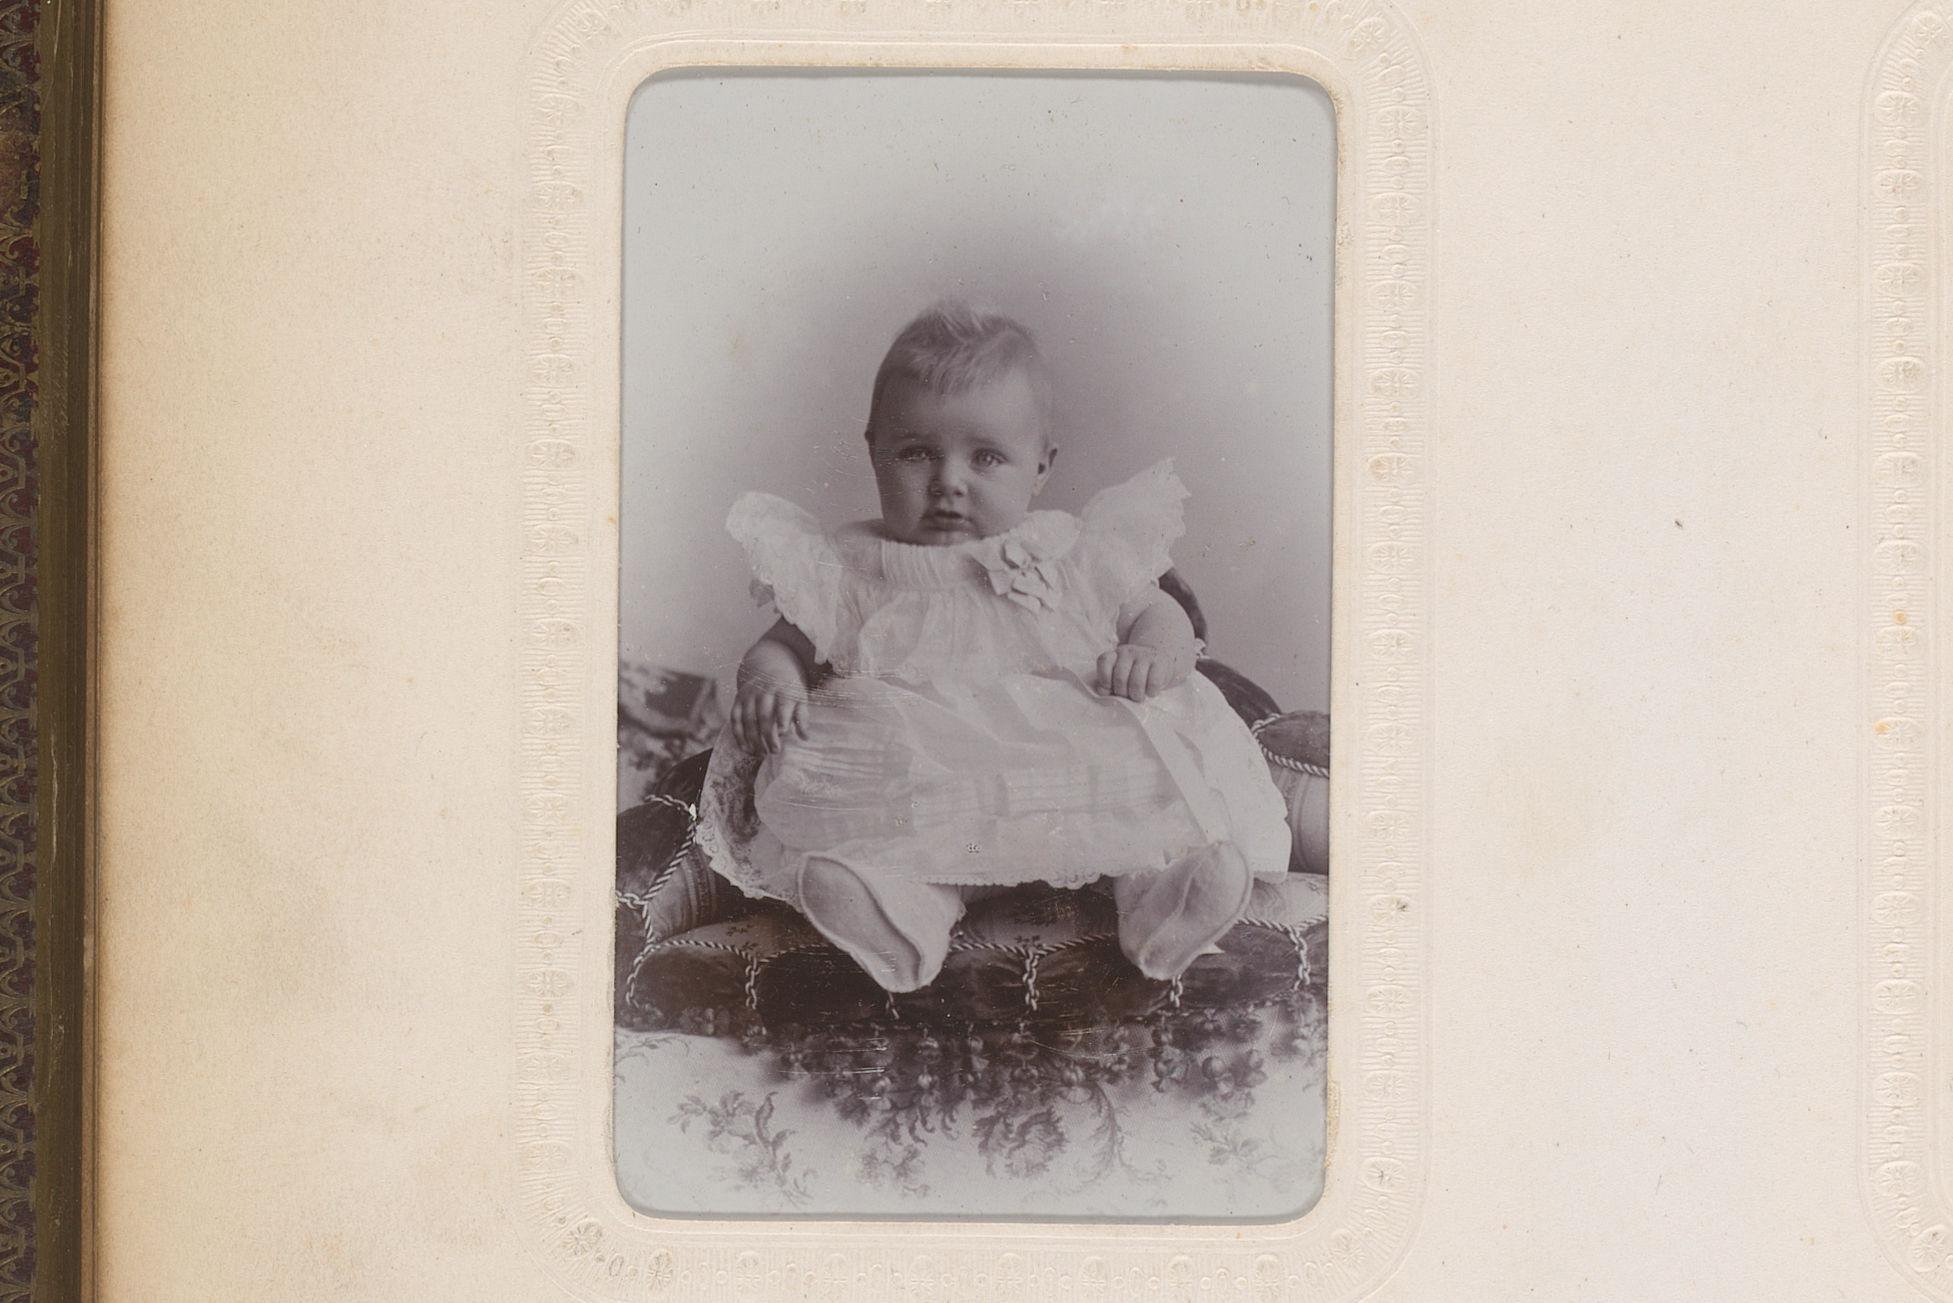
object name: album leaf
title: Portret van een jongen in matrozenpak, staand bij een tafel met open boek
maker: h.c. de graaff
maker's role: fotograaf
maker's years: 1853-1932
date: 1898-1919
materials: cardboard, photographic support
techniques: collodion silver print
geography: amsterdam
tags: ensemble of pieces of clothing: sailor suit, boy (child between toddler and youth), historical persons, book - mm - book open